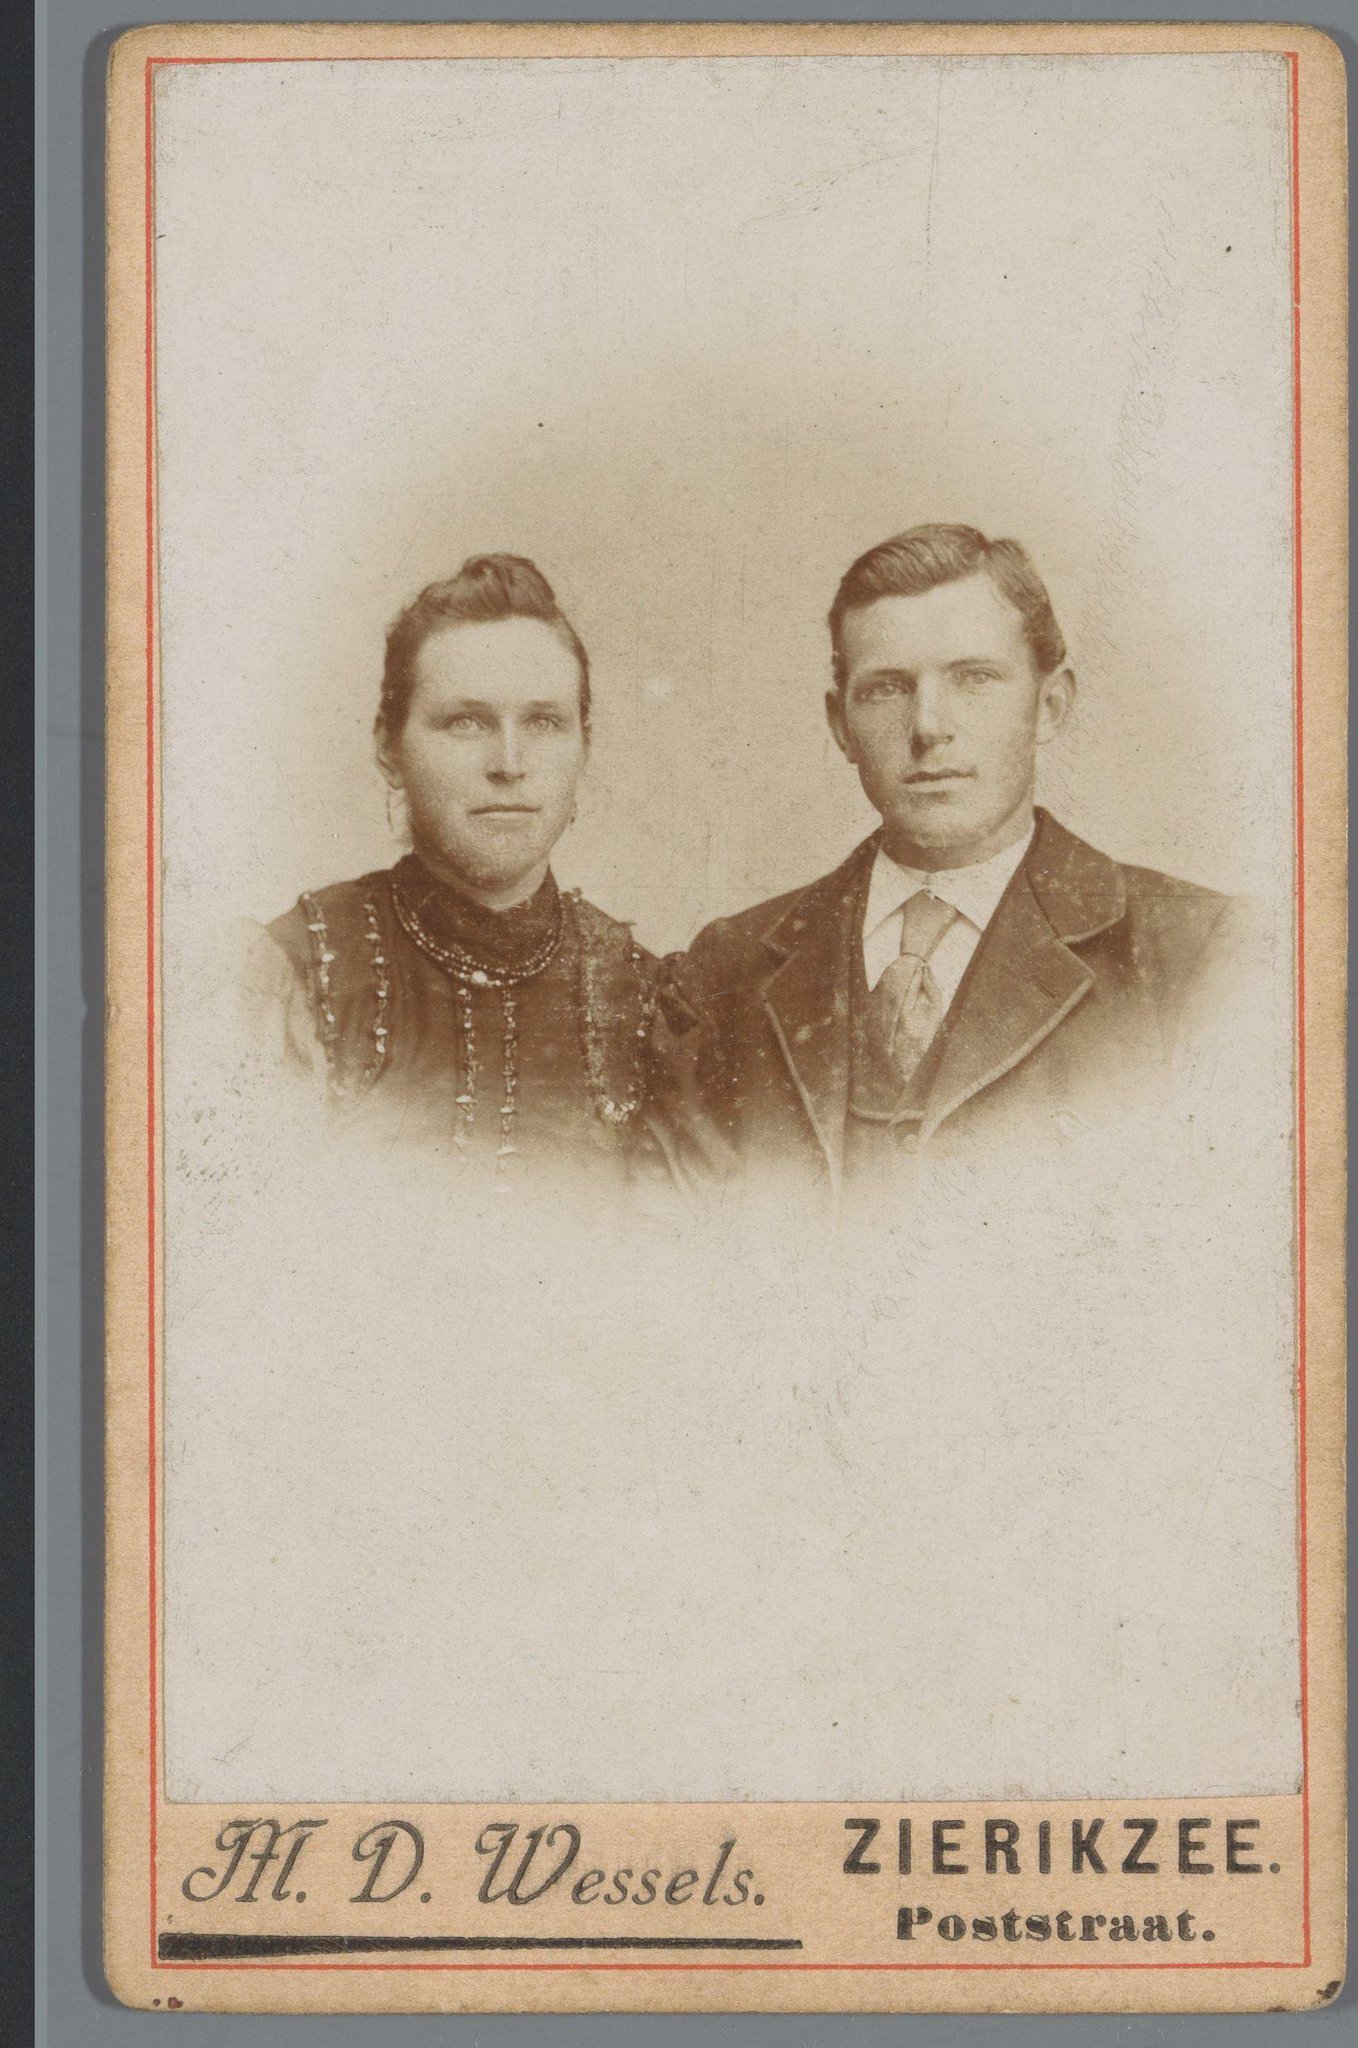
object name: semi enamel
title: Portret van een onbekende man en vrouw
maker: michiel david wessels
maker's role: fotograaf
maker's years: 1860-1928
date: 1898-1903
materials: cardboard, celluloid, paper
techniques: albumen print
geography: zierikzee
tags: adult woman, adult man, anonymous historical person portrayed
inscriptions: inscription: ‘M.D. Wessels./ Zierikzee./ Poststraat.’